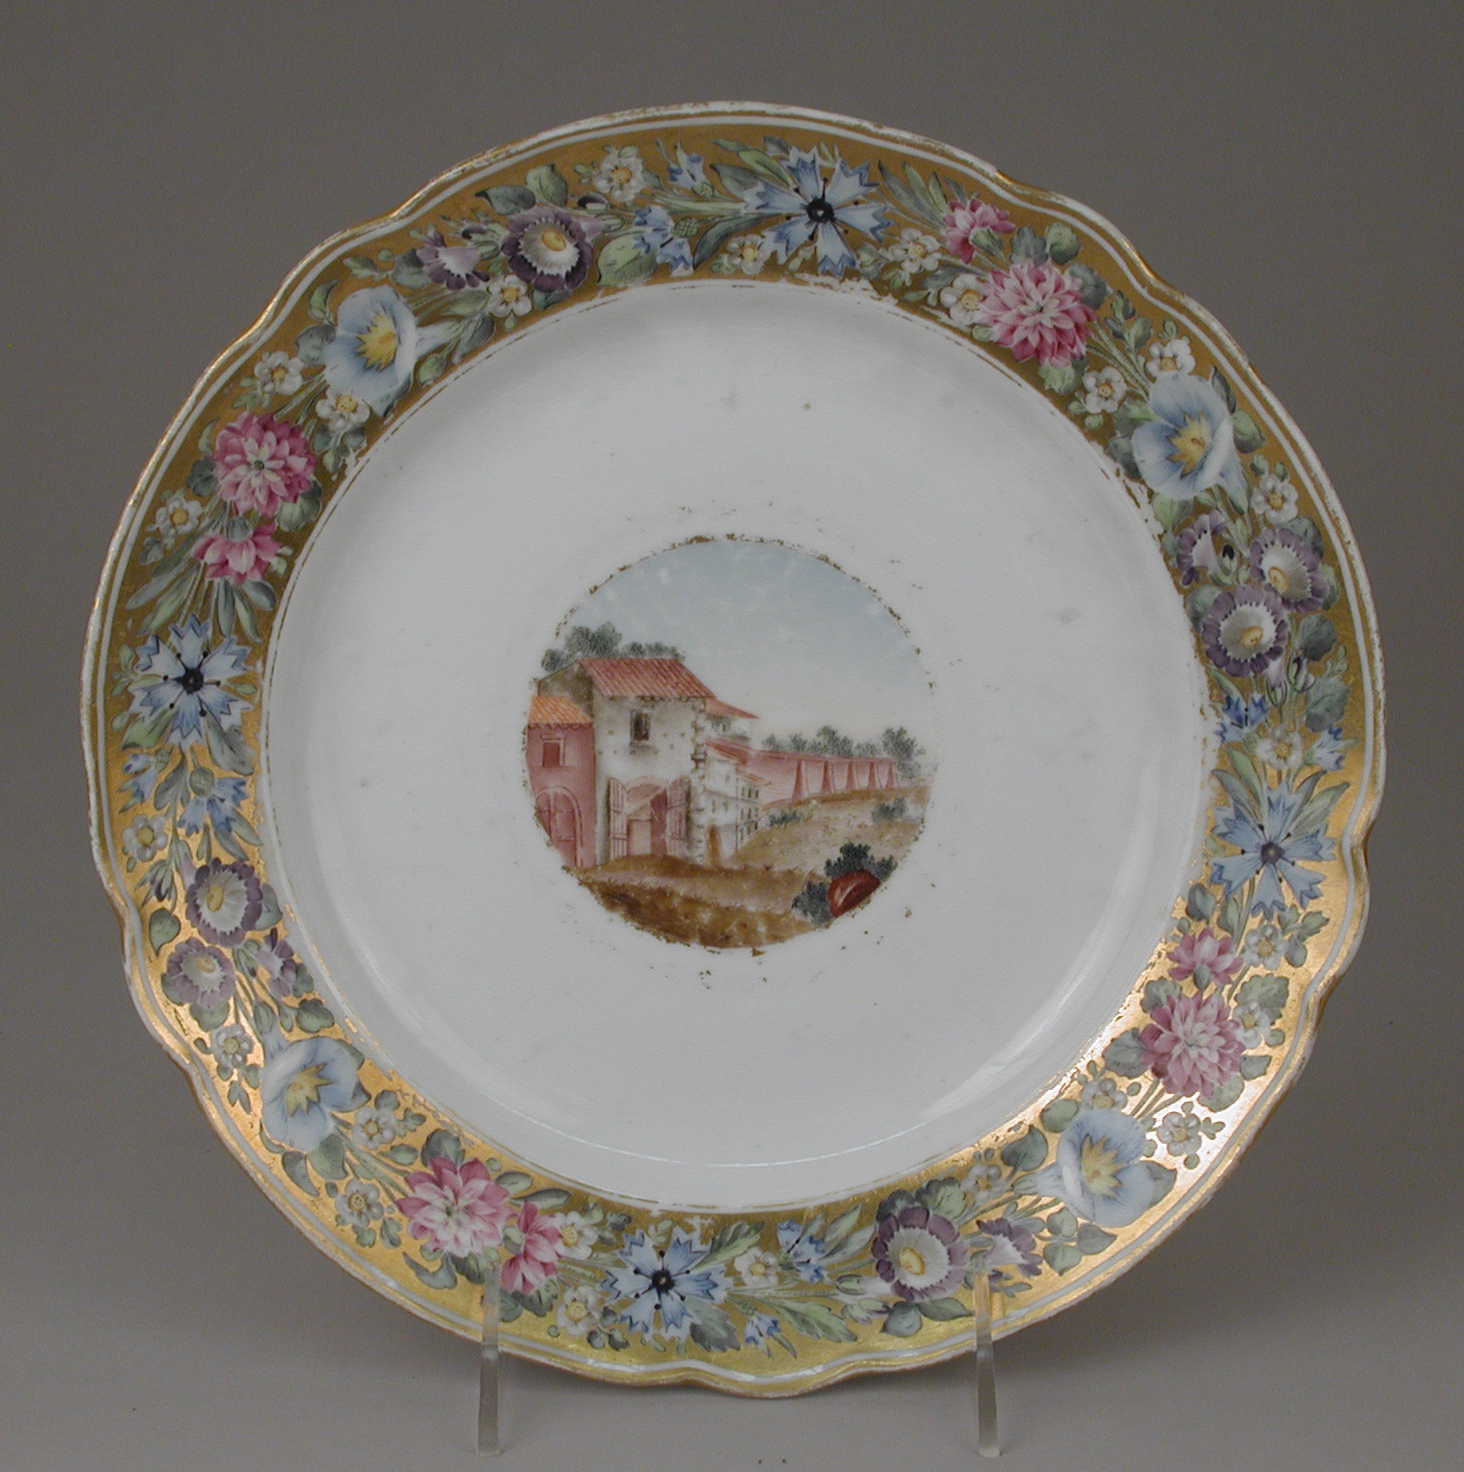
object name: plate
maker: imperial porcelain manufactory, st. petersburg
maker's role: manufactory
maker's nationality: russian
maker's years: 1744-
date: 1796-1801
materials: hard paste porcelain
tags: buildings,flowers